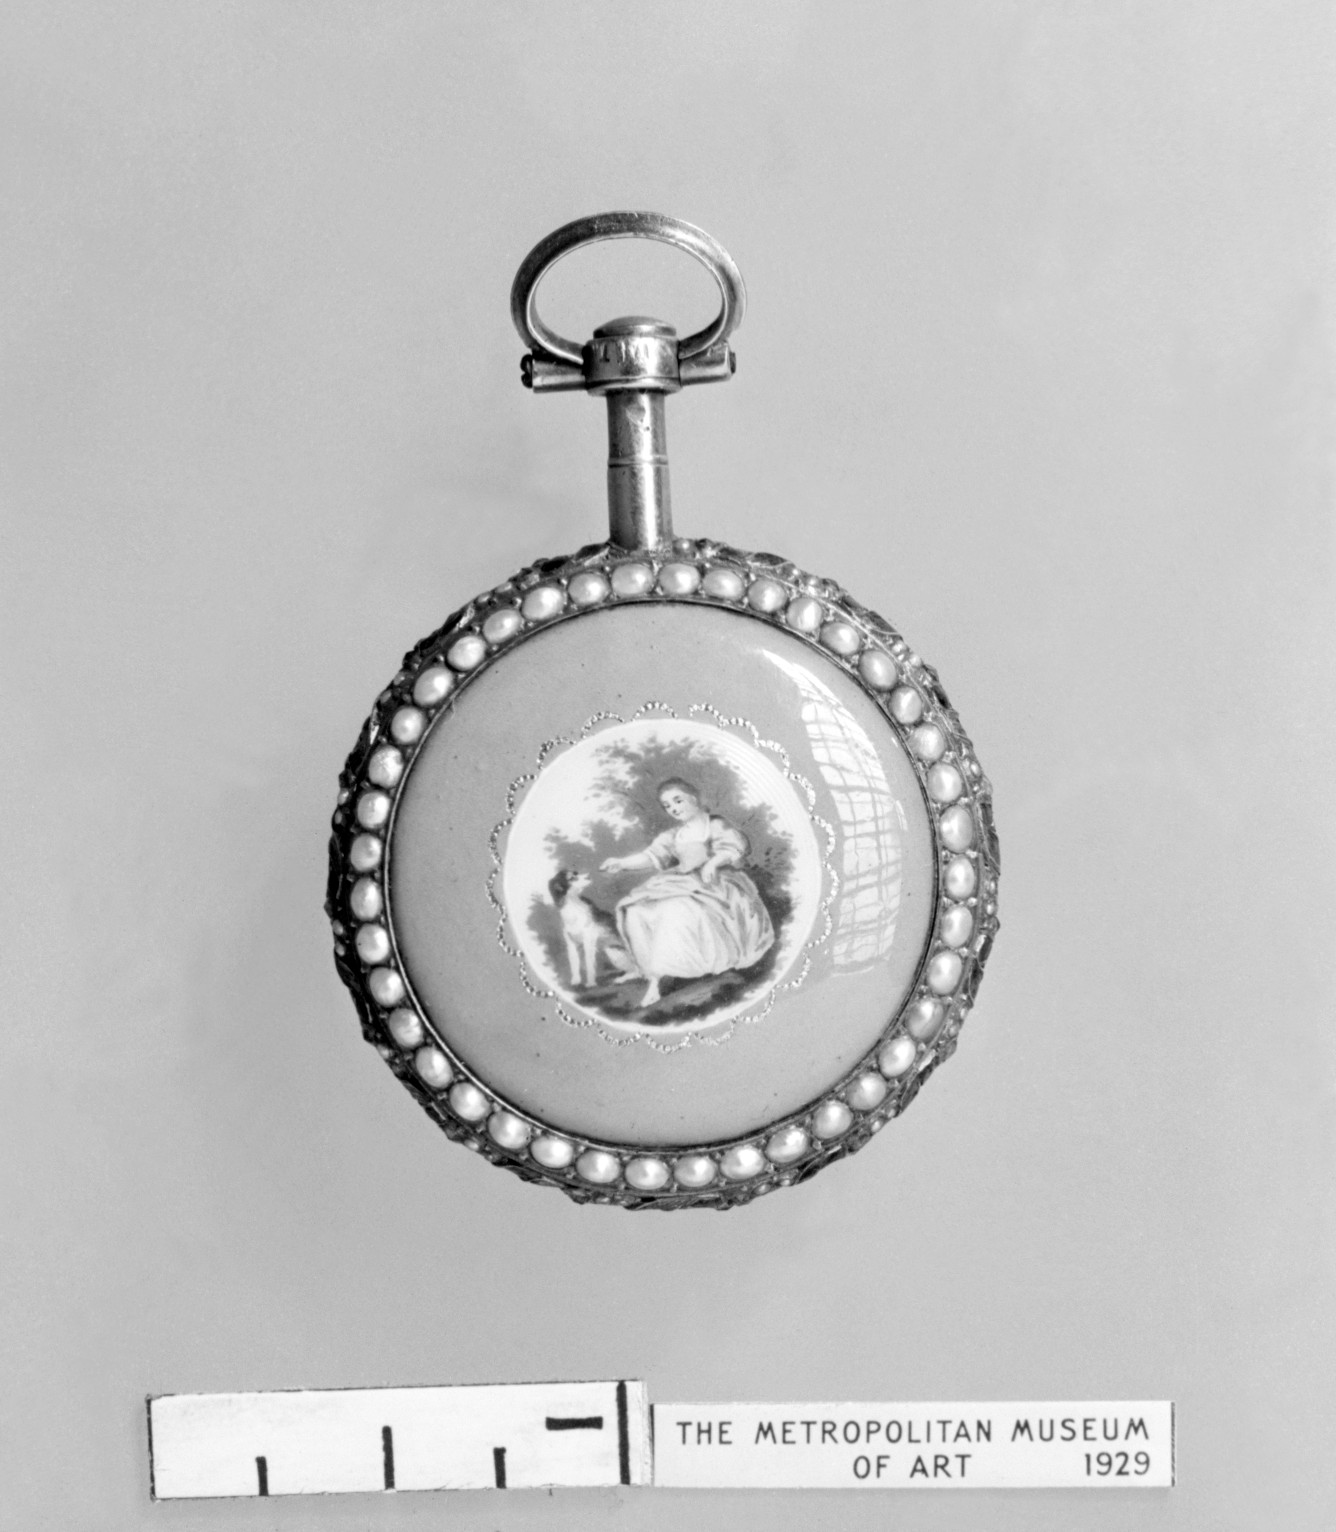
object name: watch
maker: leger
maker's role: maker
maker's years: 1750-1810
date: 1767-1800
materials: enamel, garnet, gold, pearl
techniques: painting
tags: women,dogs